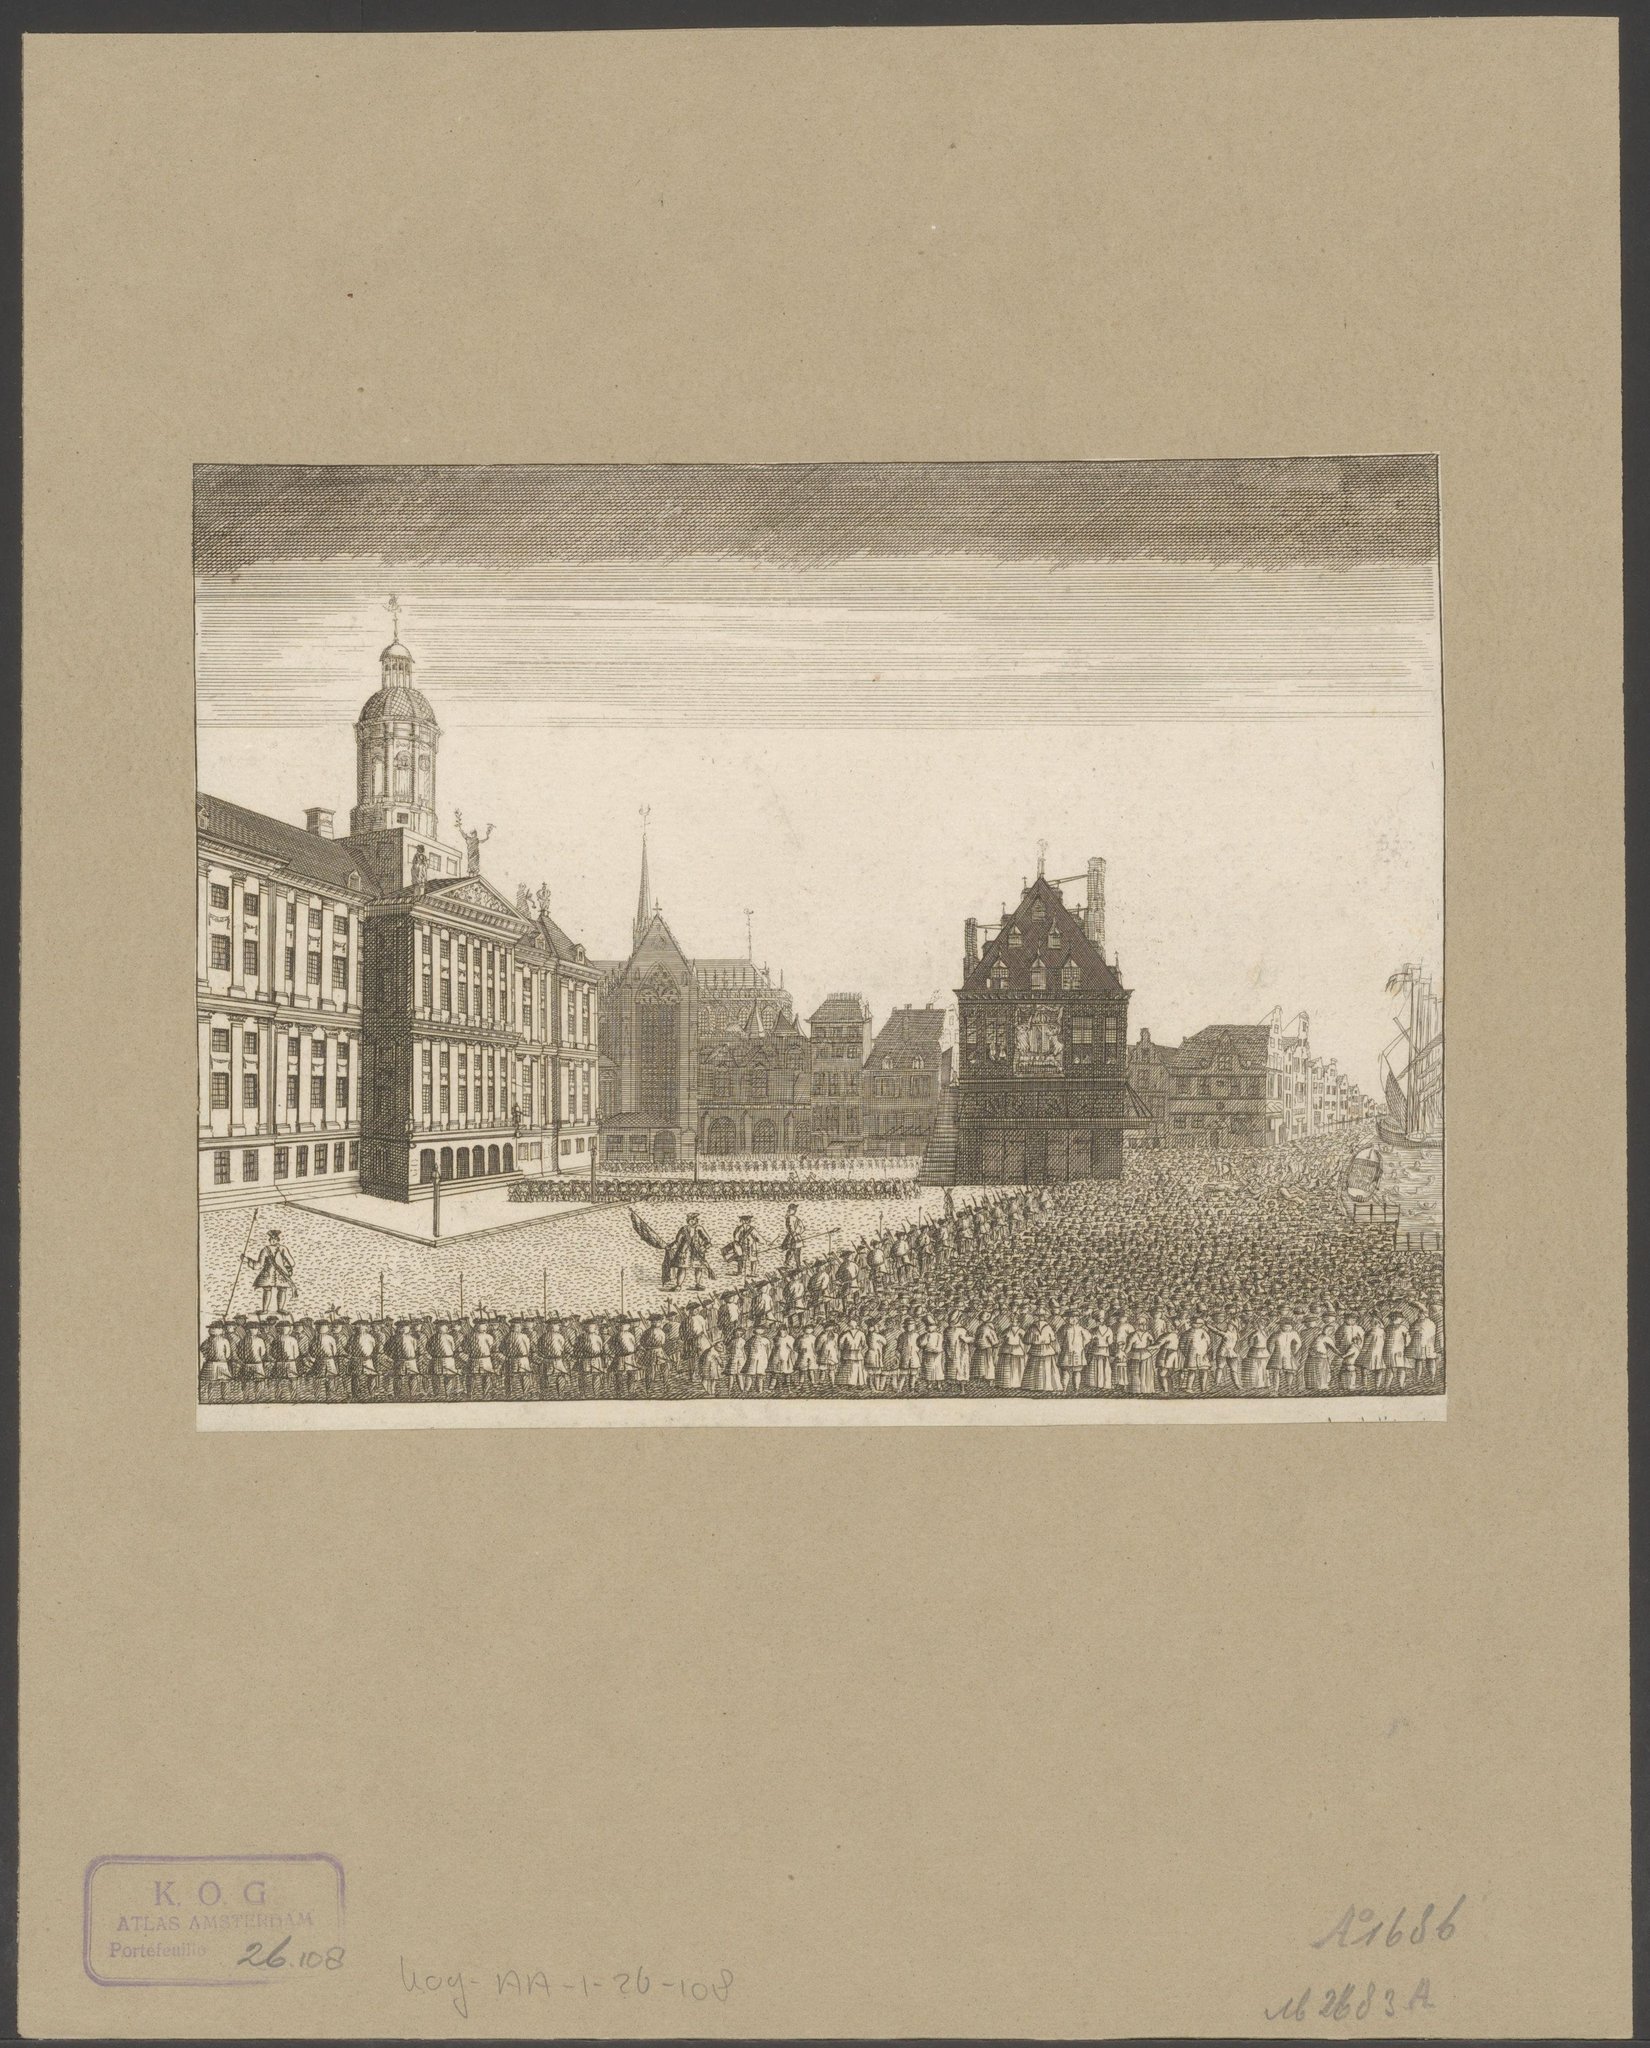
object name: print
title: Paraderende schutterijen op de Dam te Amsterdam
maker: Anonymous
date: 1700-1750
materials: paper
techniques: etching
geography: northern netherlands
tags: crowd, mob, military parade, pageant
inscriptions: collector's mark: Lugt 1641b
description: Onderwerpsrubriek binnen de Atlas Amsterdam: Herinneringen aan de Schutterij.